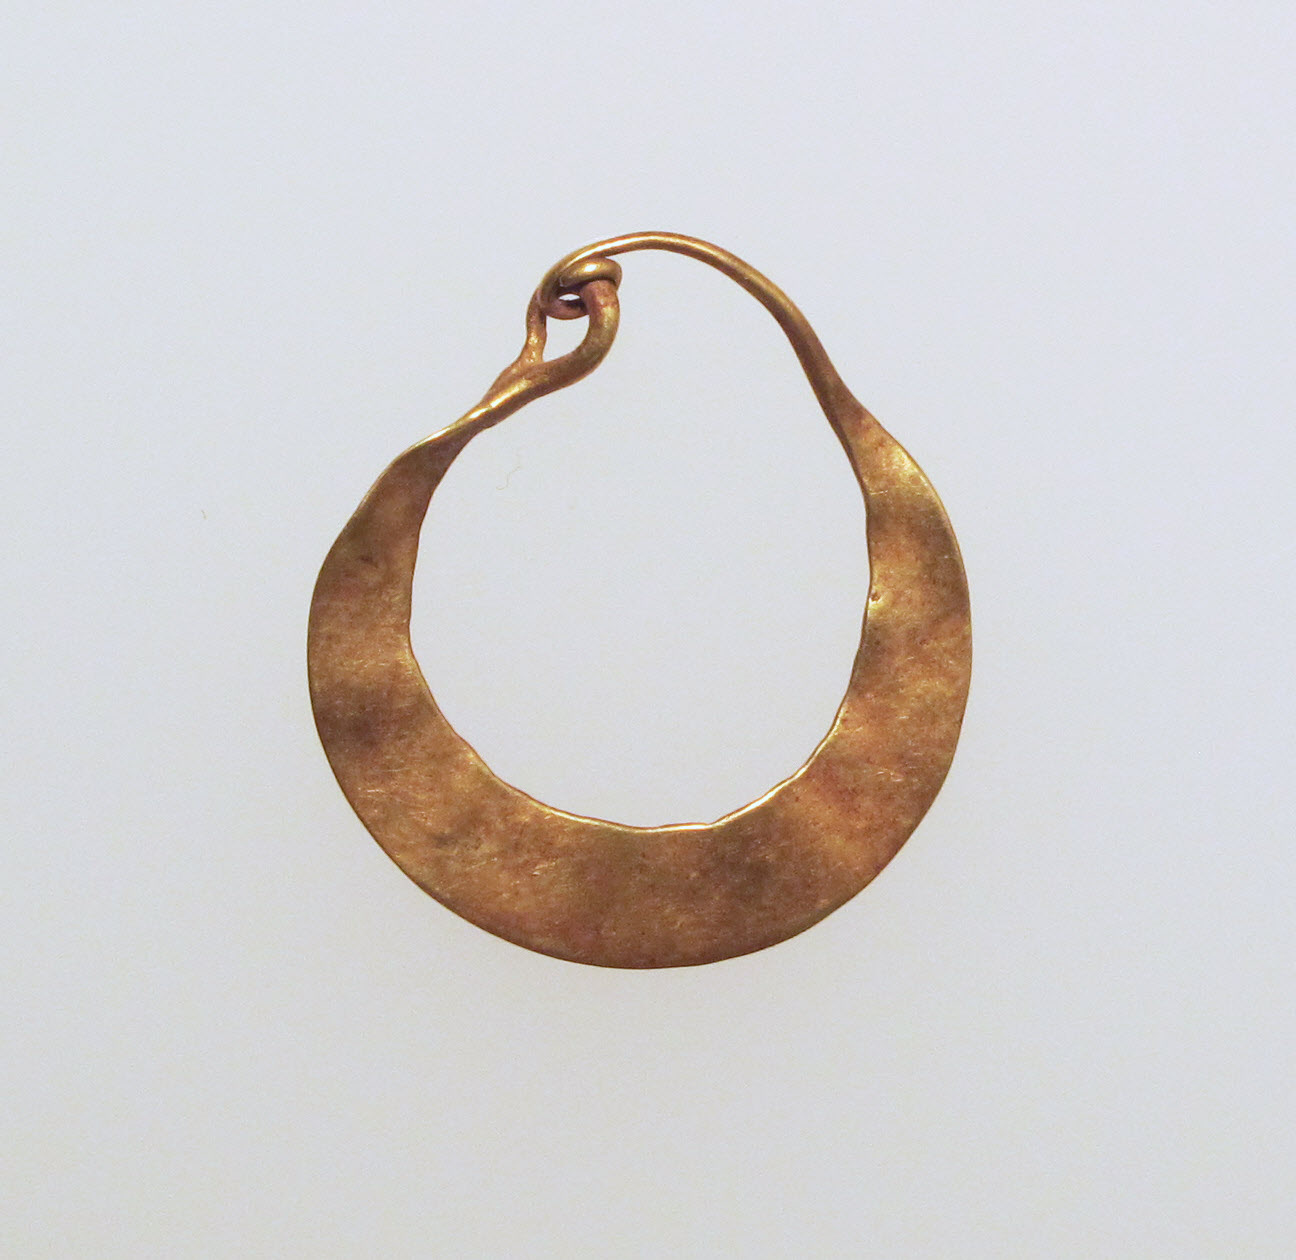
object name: earring, crescent shaped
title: Earring, crescent-shaped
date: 7000 BCE-330 CE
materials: gold